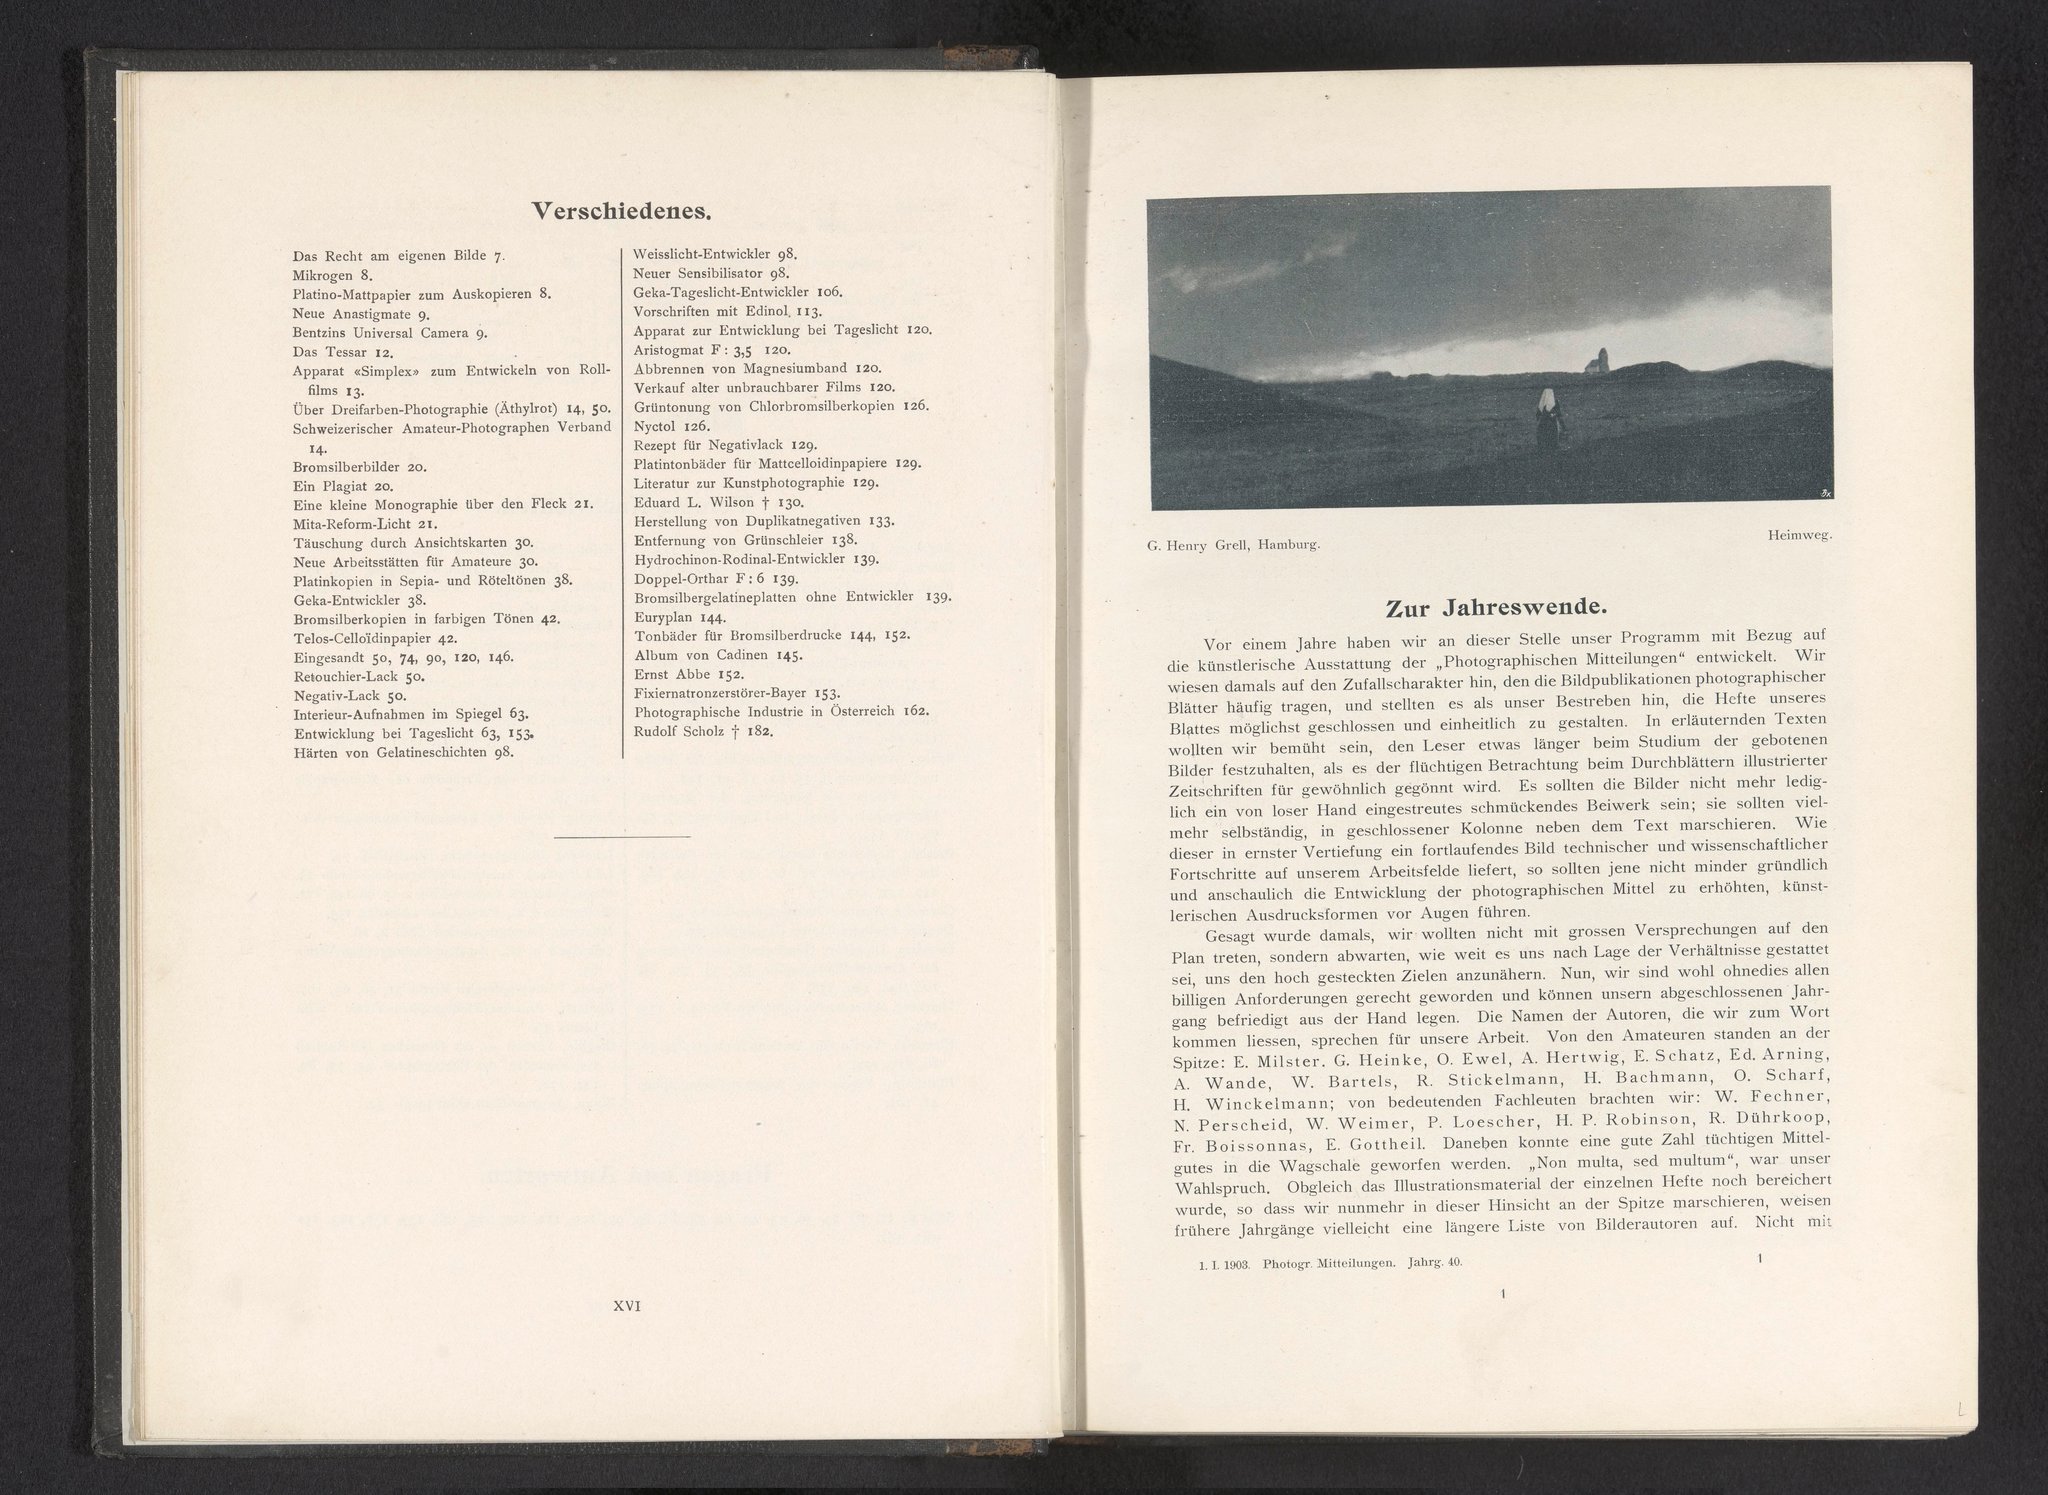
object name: page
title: Landschap met wandelende non en een kerk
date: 1898-1903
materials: paper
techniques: autotype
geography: hamburg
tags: landscapes, nun(s), church (exterior)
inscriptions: monogram: ‘BX’